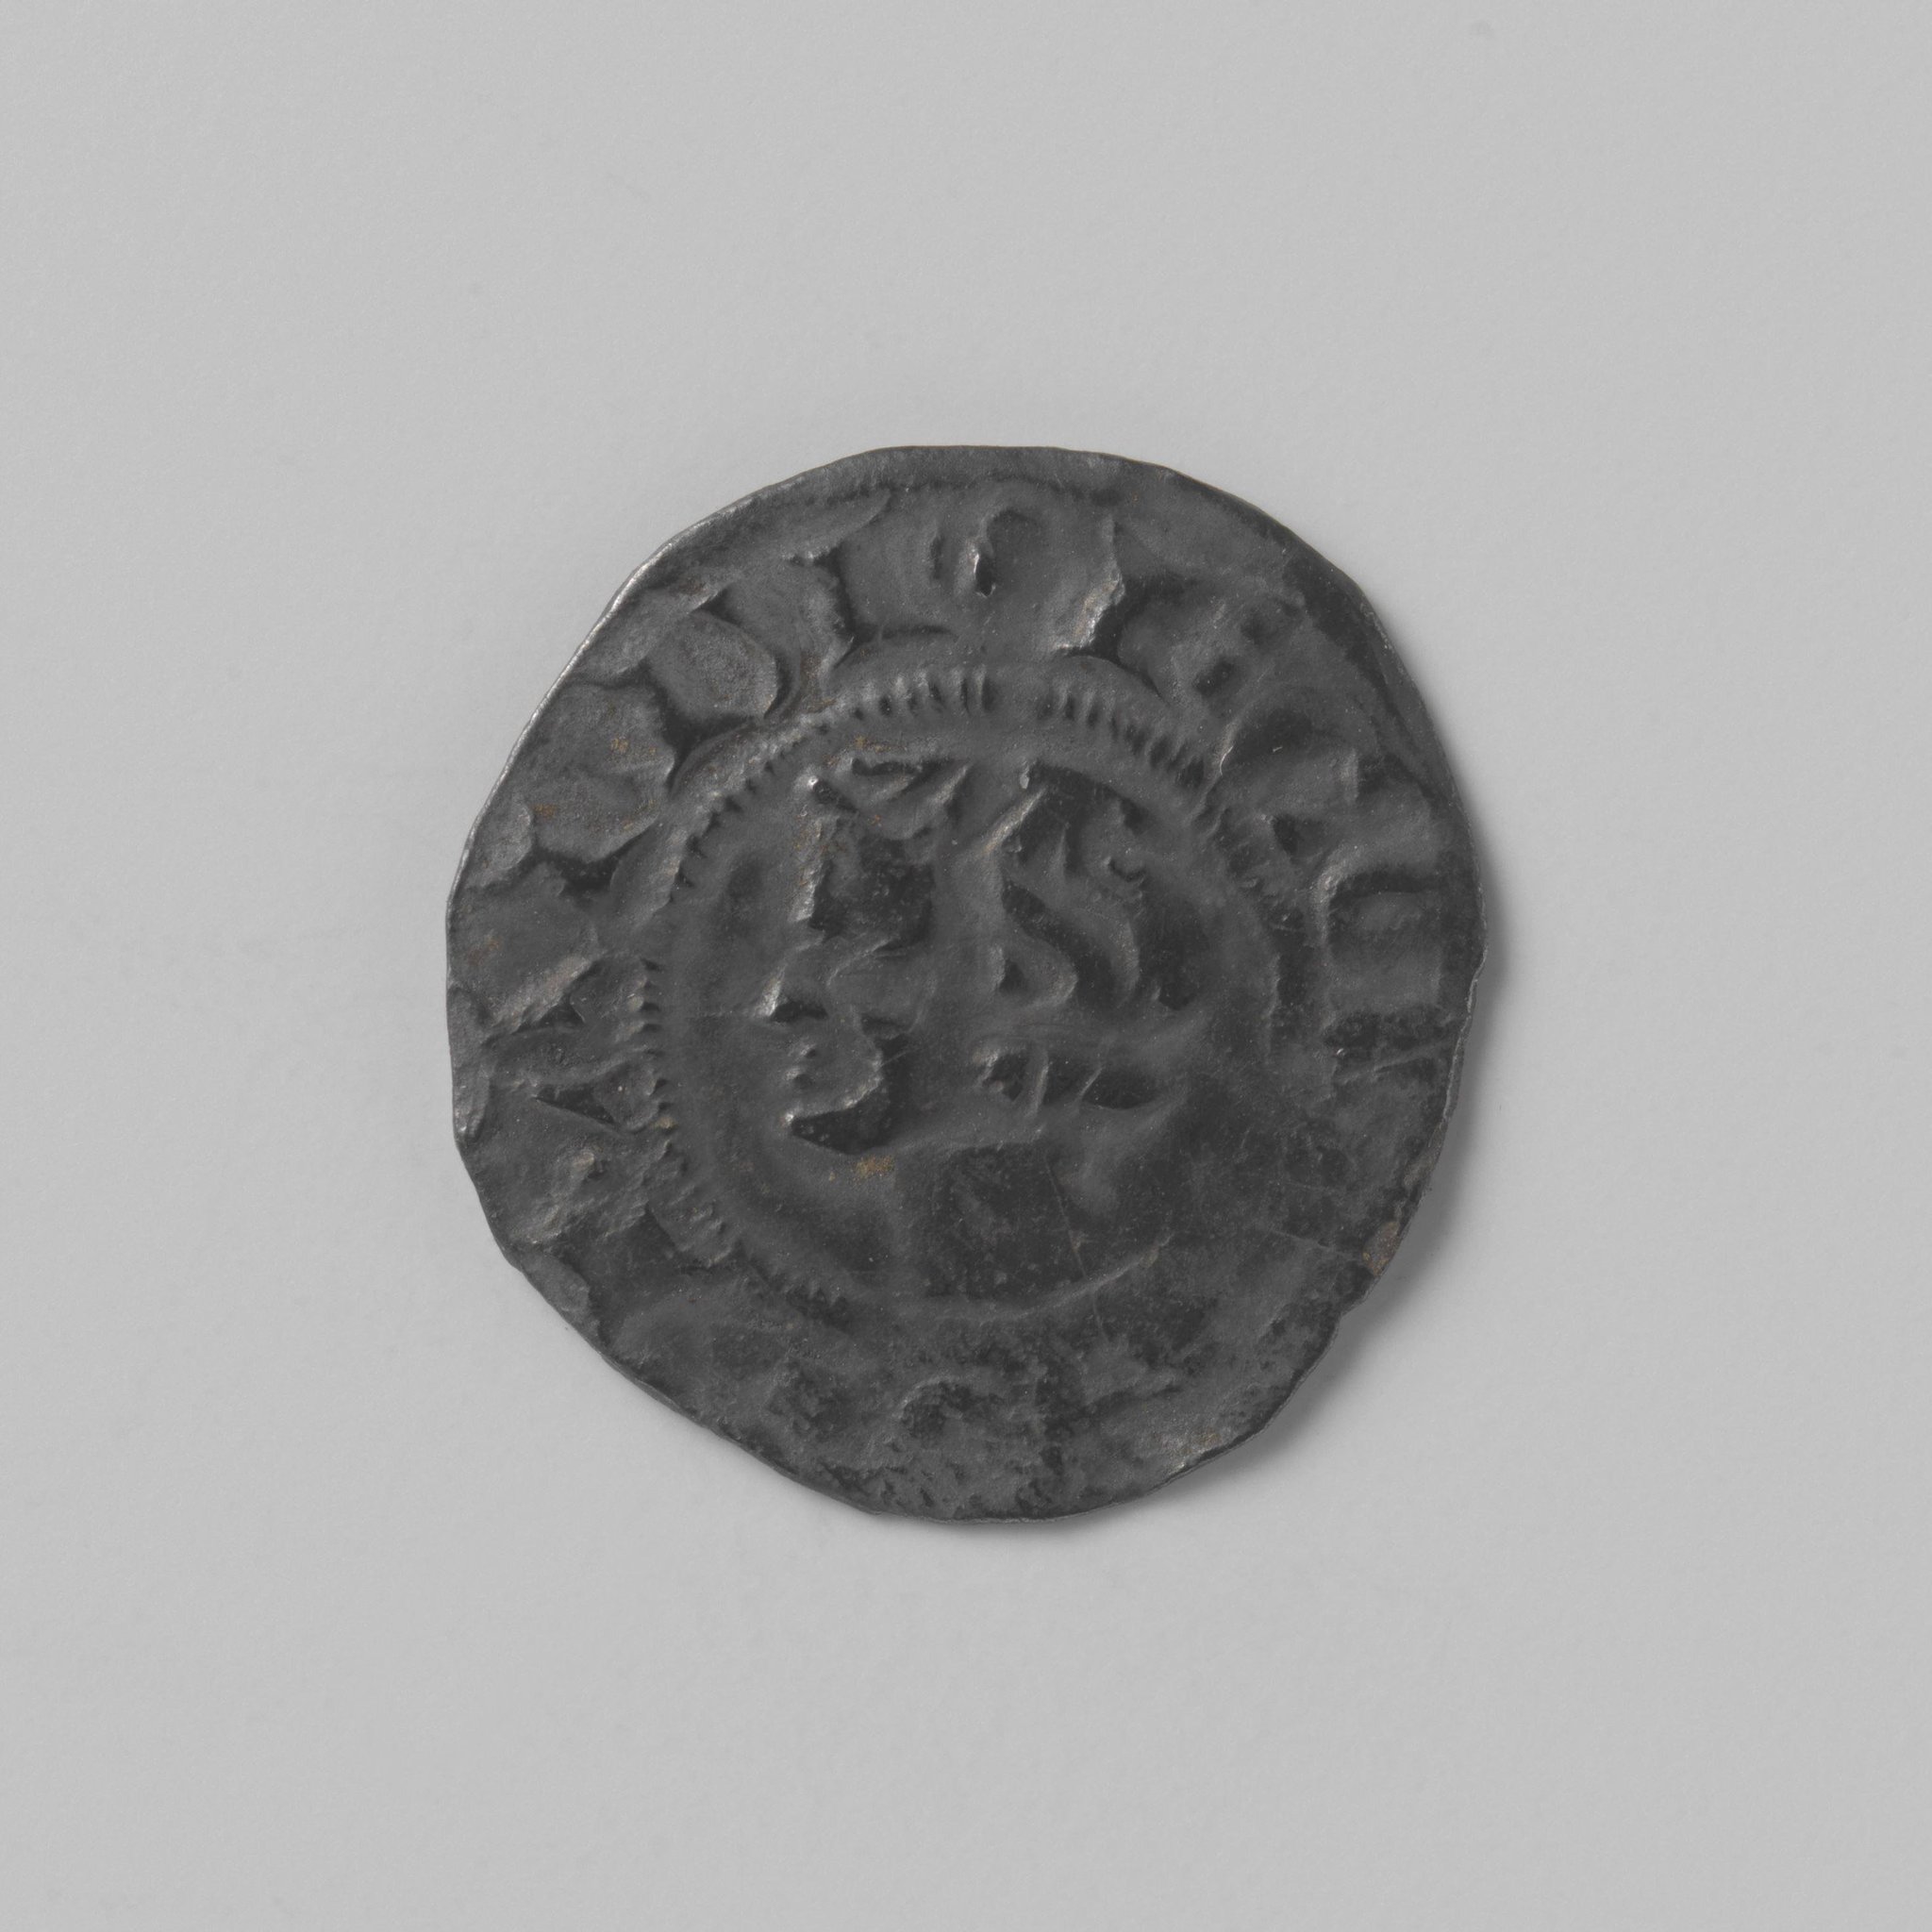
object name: coin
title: Hollandse penning van Floris V, 1256-1296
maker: floris v (graaf van holland en zeeland)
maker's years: 1254-1296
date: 1293-1296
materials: silver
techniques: striking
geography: dordrecht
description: Zilveren munt. Voorzijde: hoofd zonder gravenmuts naar links. Keerzijde: lang glad kruis, in hoeken roosjes.